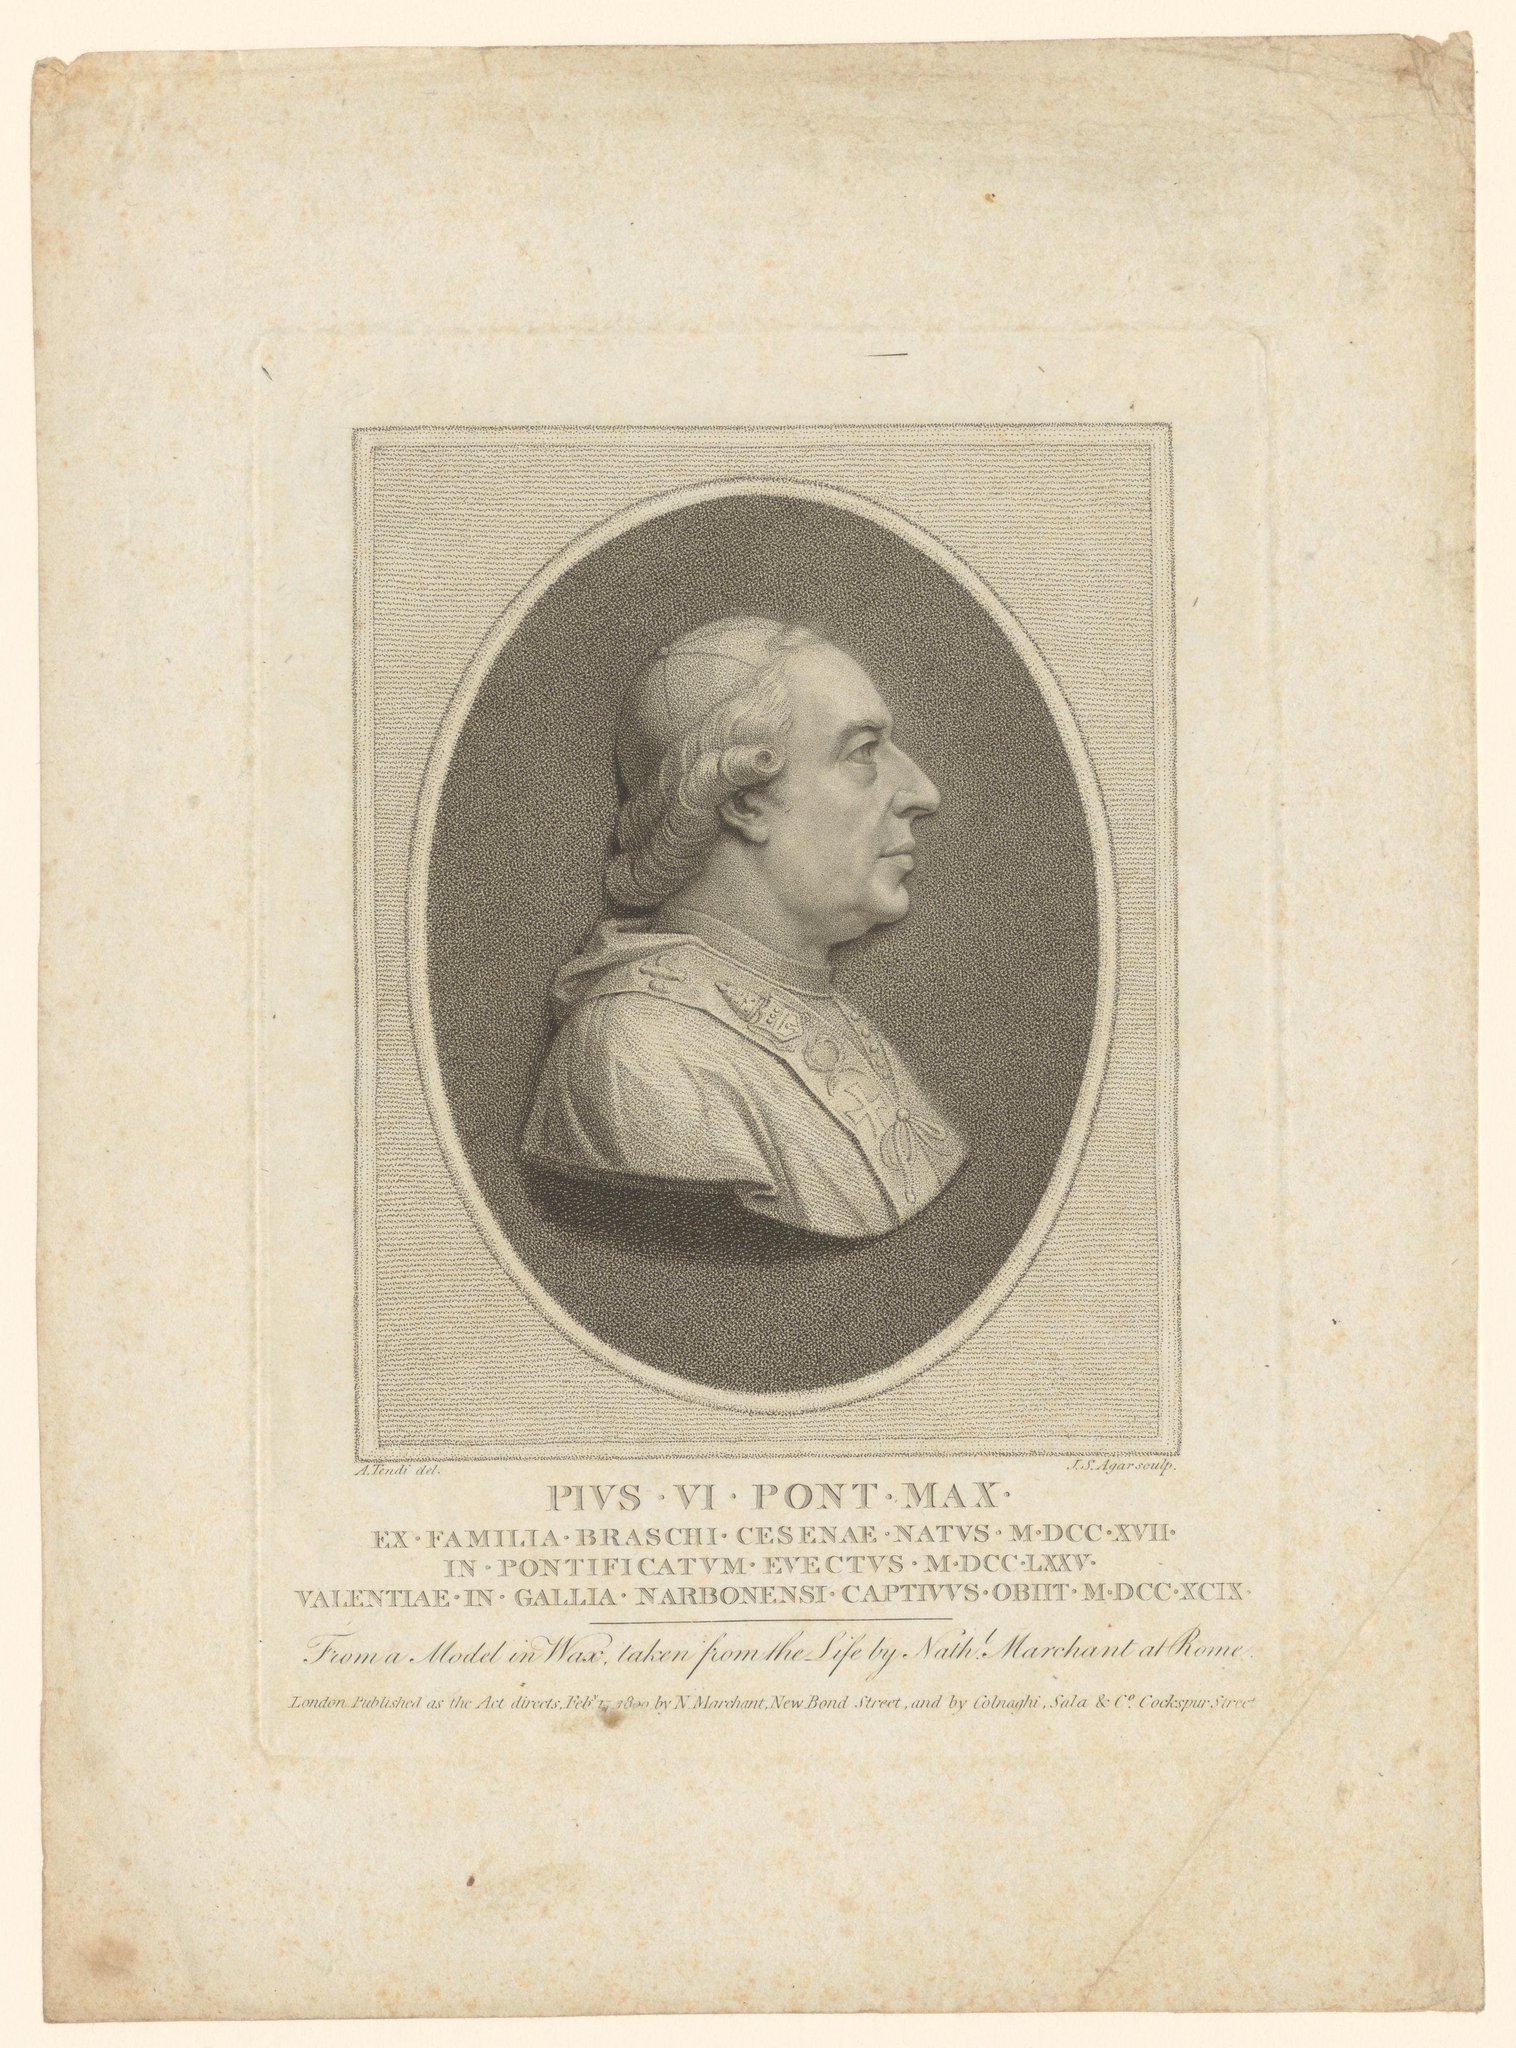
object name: print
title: Pius VI Pont Max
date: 1800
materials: paper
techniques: etching, engraving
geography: london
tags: pius vi, historical persons, pope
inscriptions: collector's mark: Lugt 2228